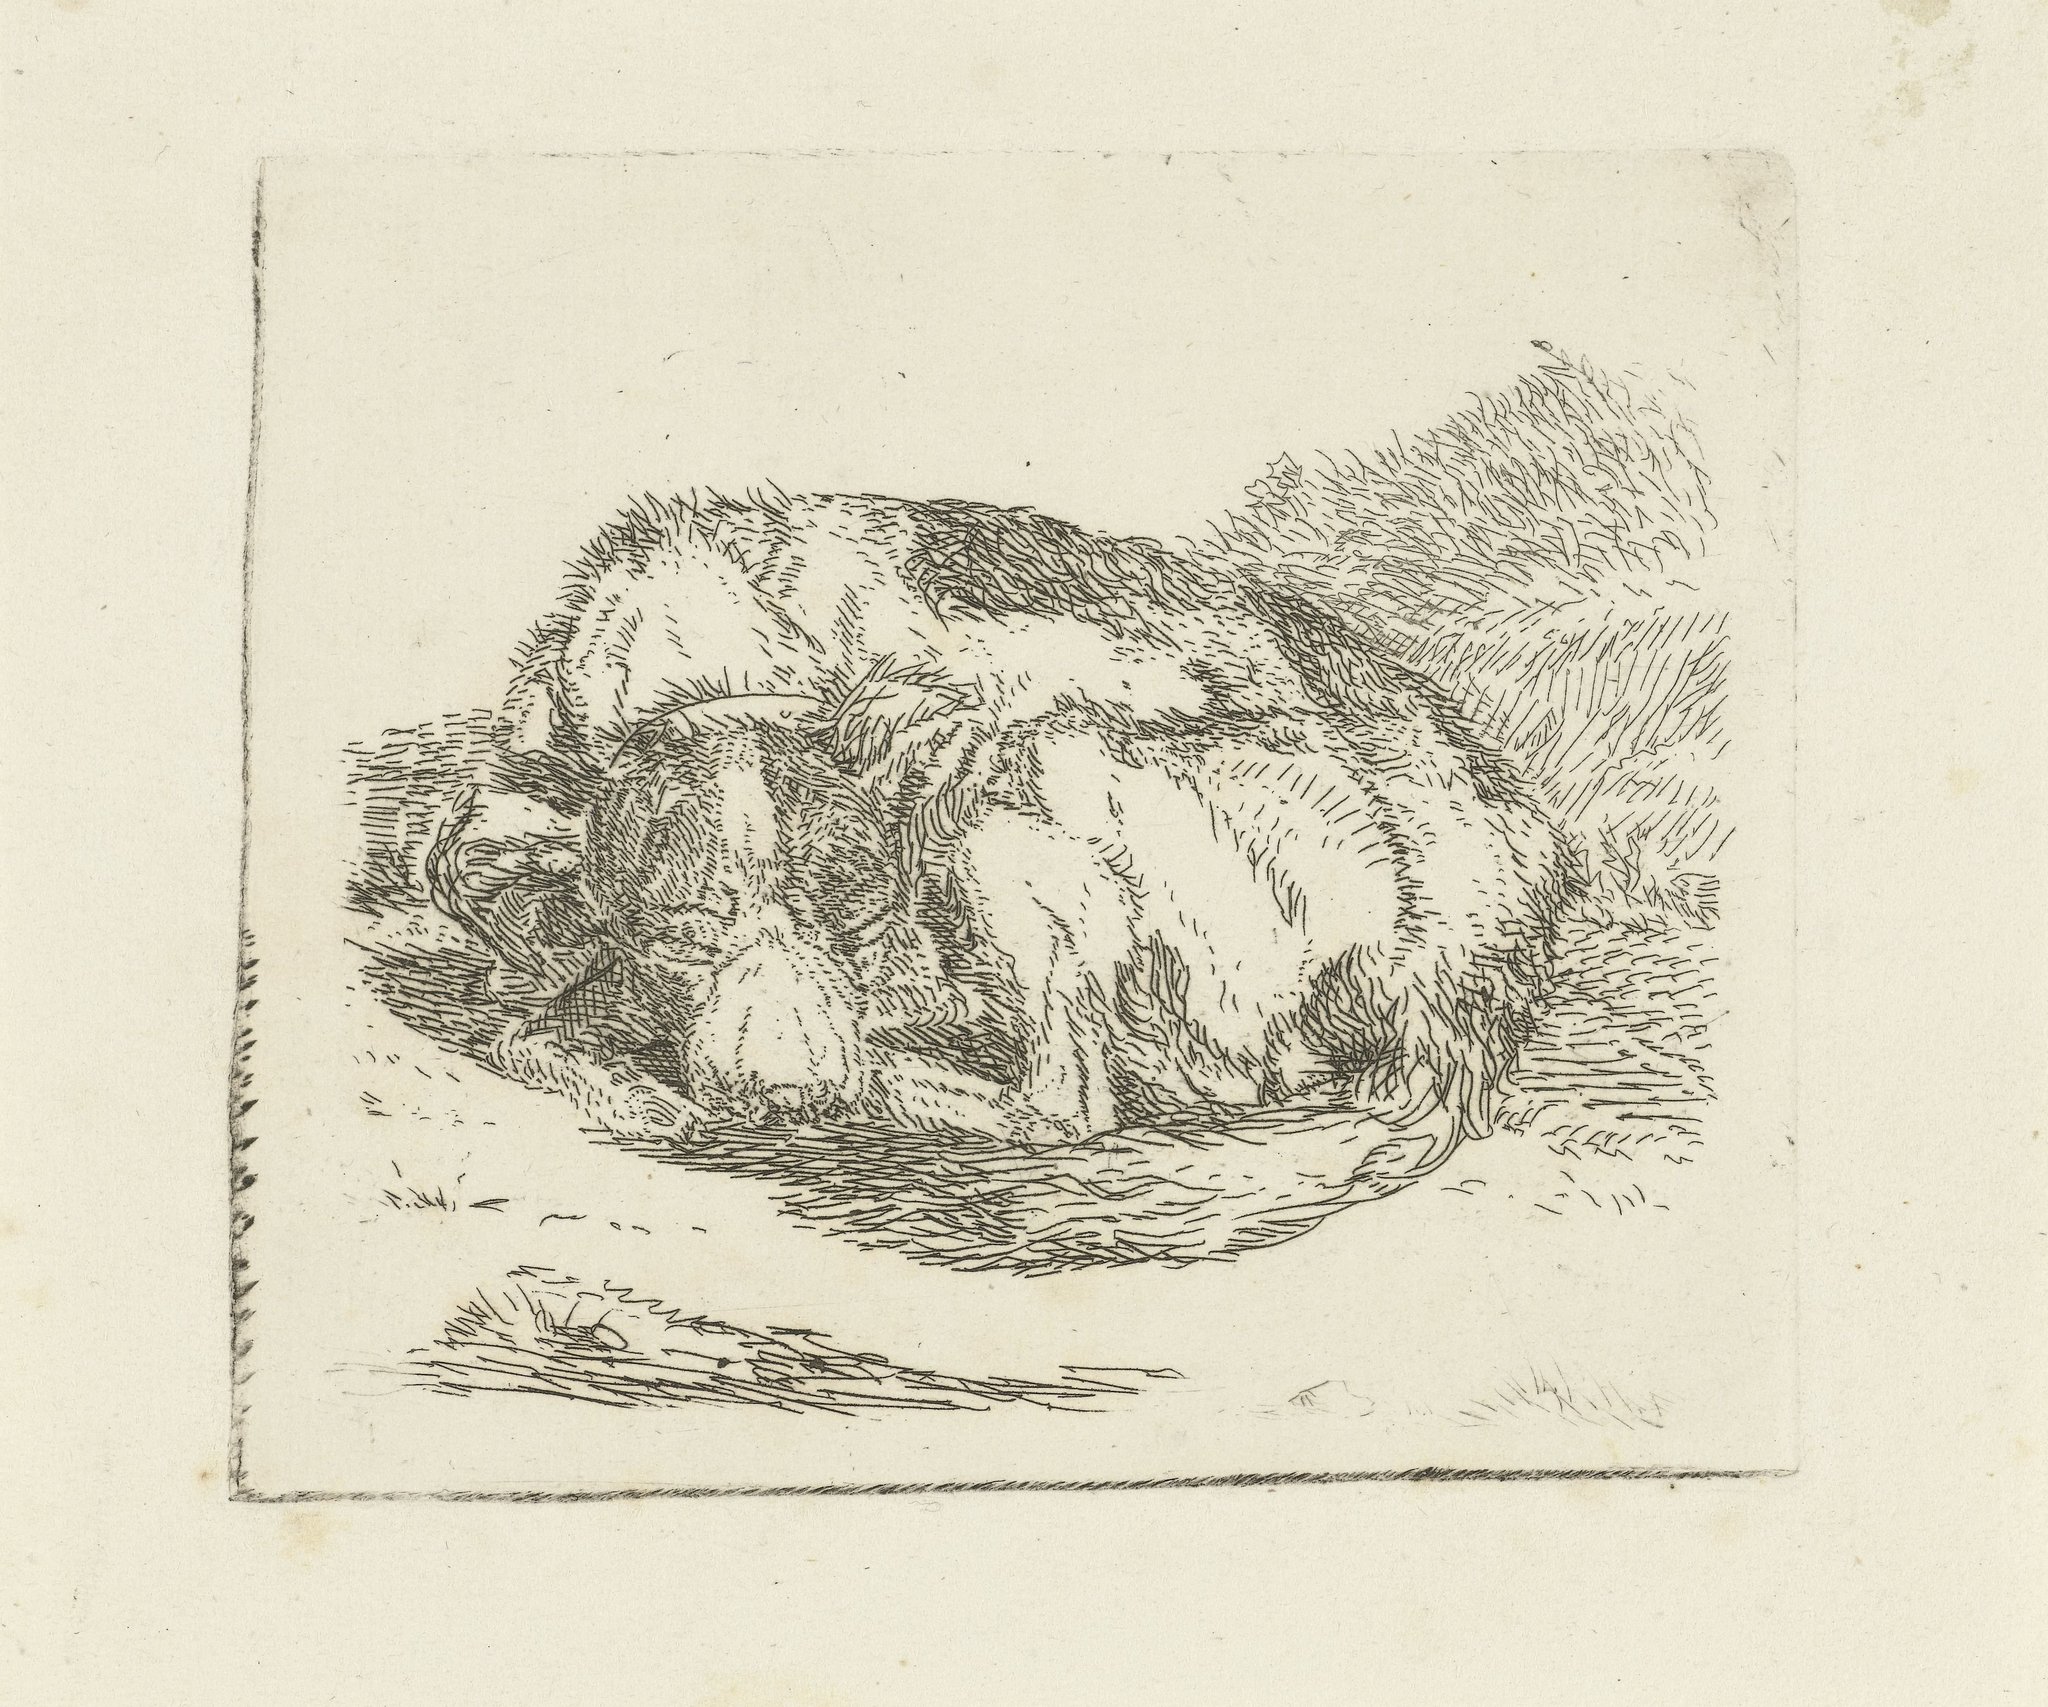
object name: print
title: Slapende hond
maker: jan dasveldt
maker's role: draughtsman, print maker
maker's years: 1770-1855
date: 1780-1855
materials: paper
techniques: etching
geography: amsterdam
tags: dog (+ sleeping animal(s))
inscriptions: collector's mark: Lugt 2228